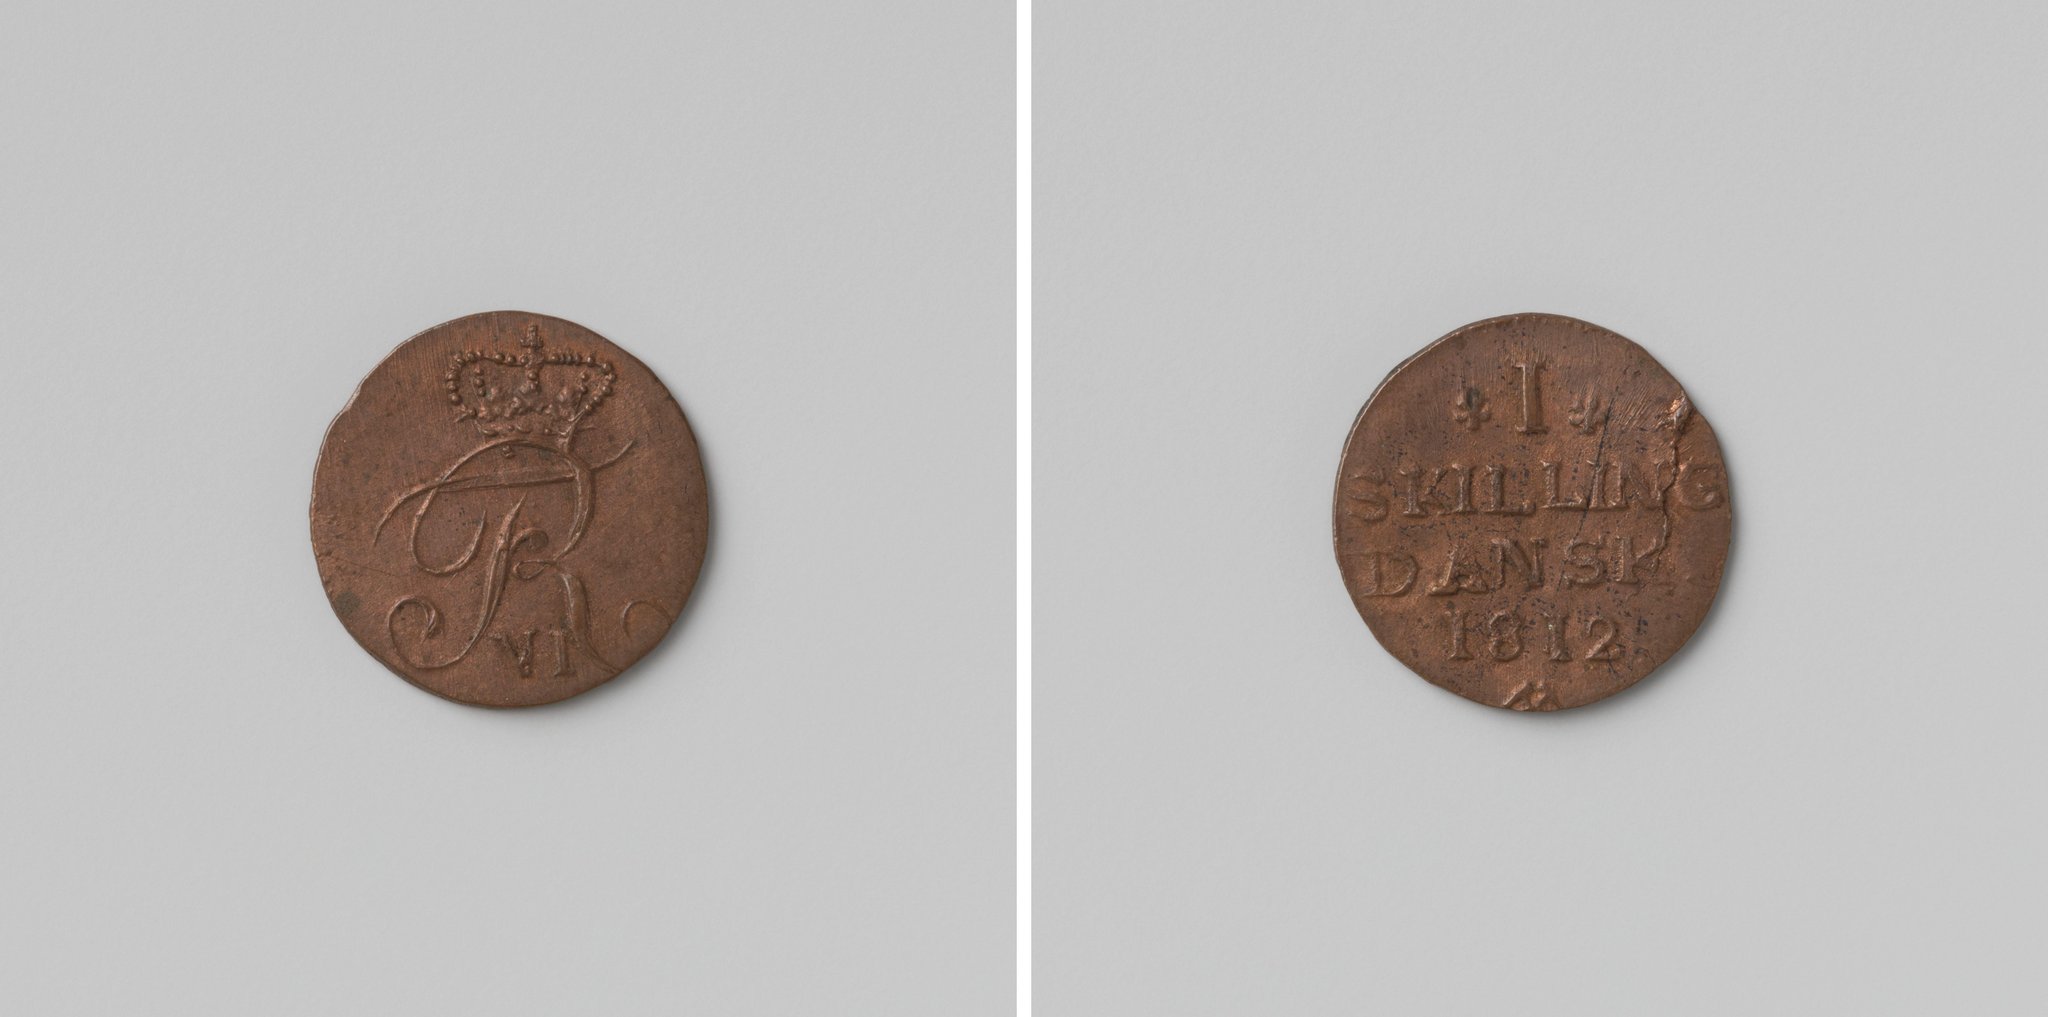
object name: coin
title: Shilling van Frederik VI, koning van Denemarken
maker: Anonymous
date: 1812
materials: copper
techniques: striking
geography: denmark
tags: copenhagen (city)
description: Koperen munt. Voorzijde: gekroond monogram van letters F en R; tussen poten van letter R: Romeins cijfer VI. Keerzijde: opschrift.